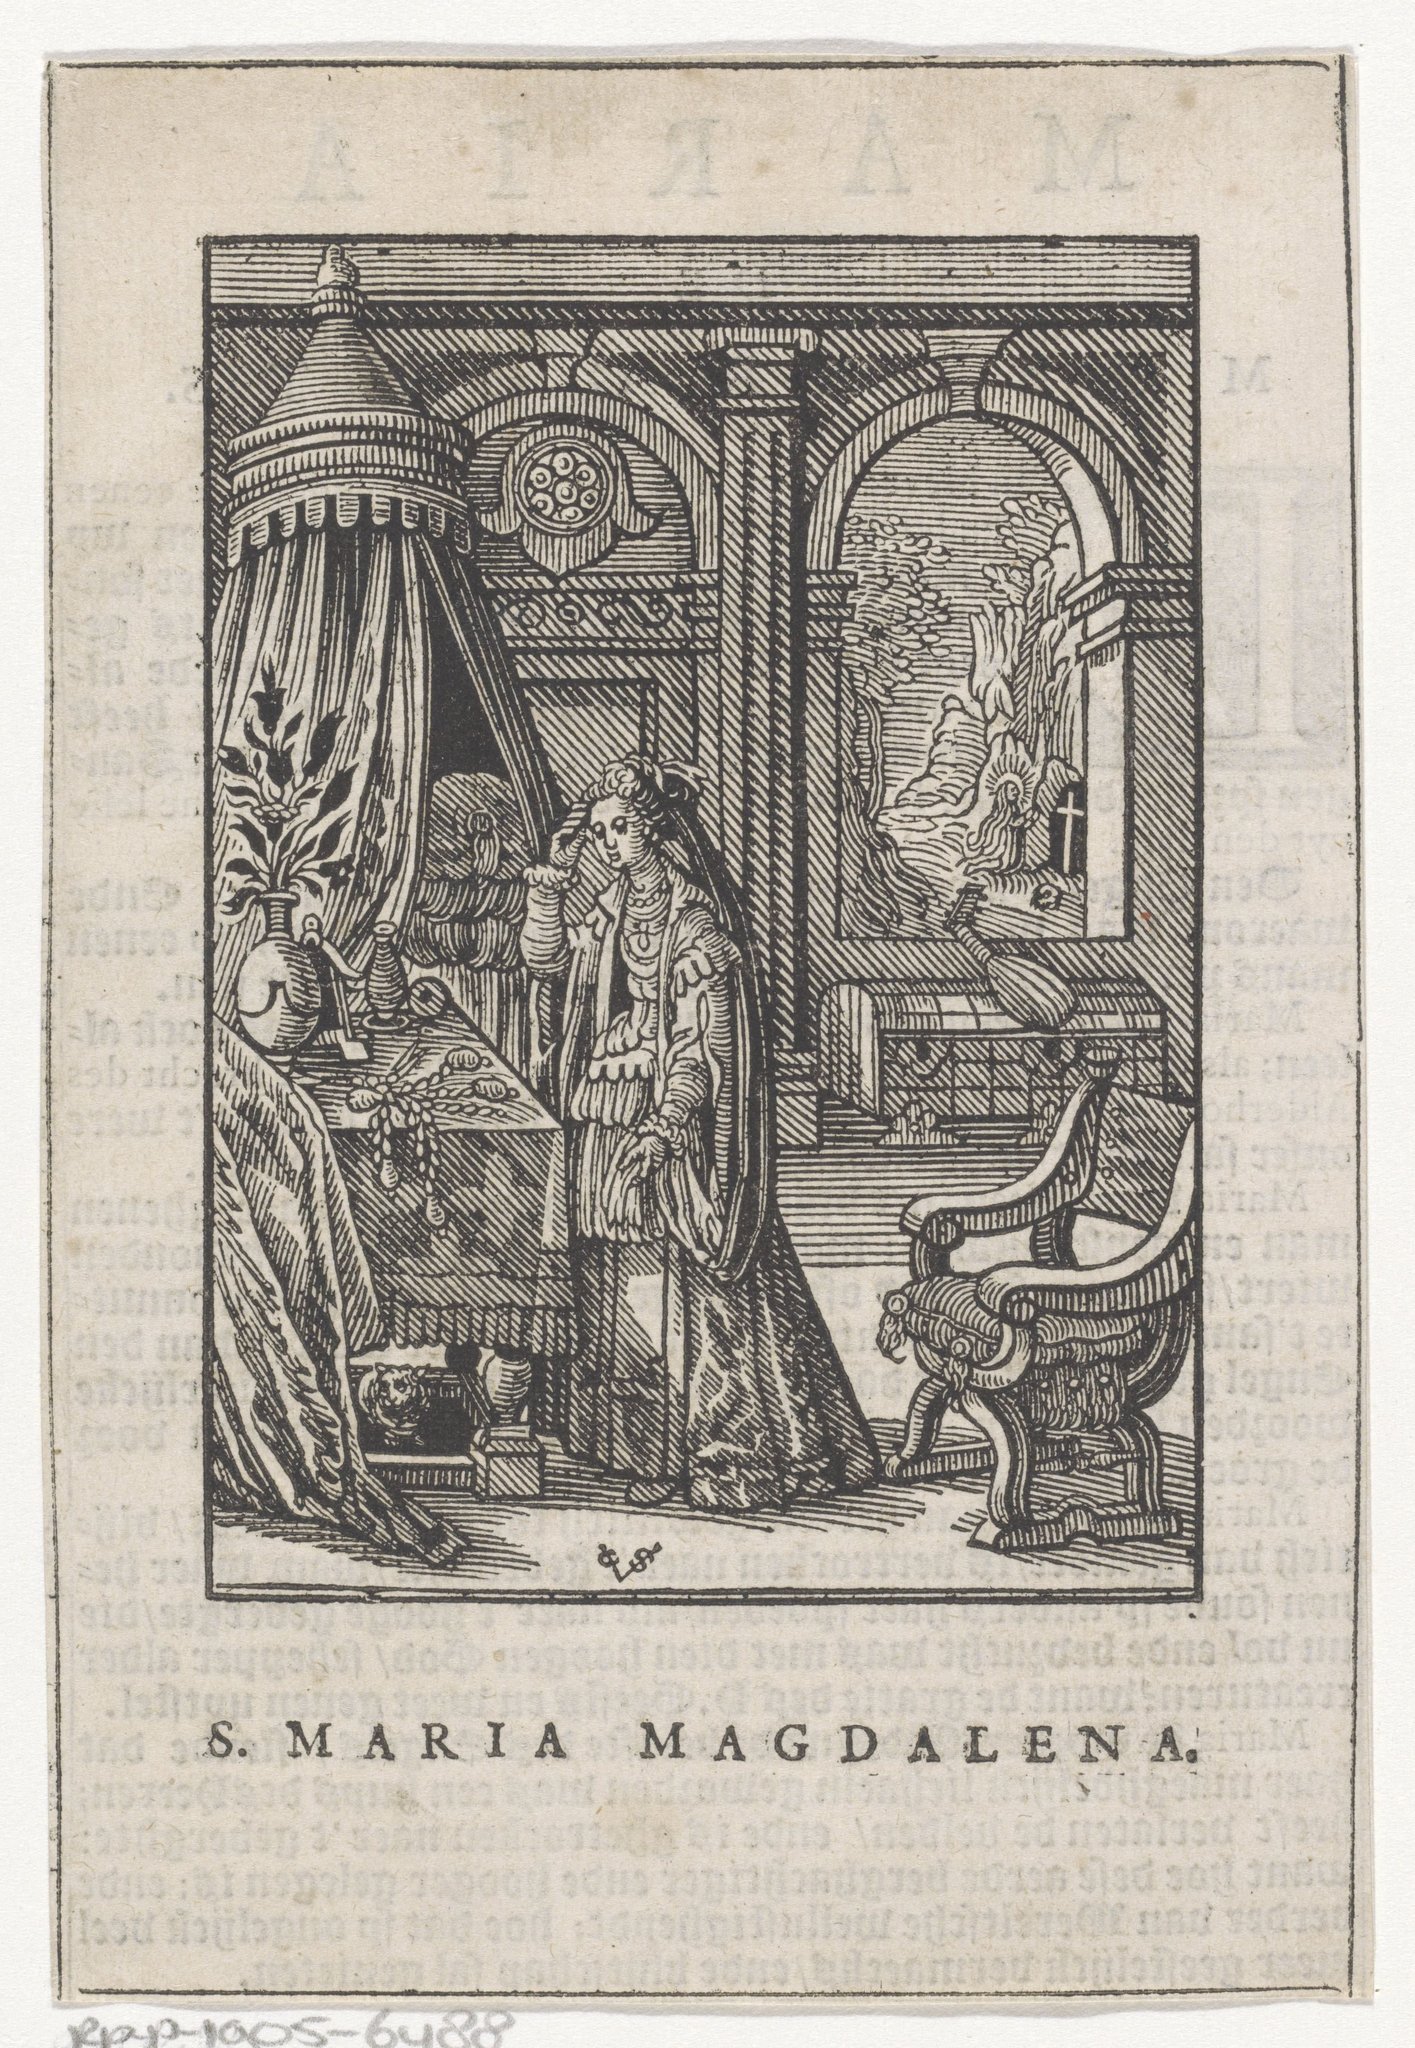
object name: print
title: S. Maria Magdalena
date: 1644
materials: paper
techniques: letterpress printing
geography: amsterdam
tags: anchorite, hermit, the penitent harlot mary magdalene; possible attributes: book (or scroll), crown, crown of thorns, crucifix, jar of ointment, mirror, musical instrument, palm-branch, rosary, scourge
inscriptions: collector's mark: Lugt 2228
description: Prent uit: Rosweyde, Heribert. 'tBosch der eremyten ende eremitinnen, van Aegypten ende Palestinen. Amsterdam: Pieter Jacobsz. Paets, 1644.